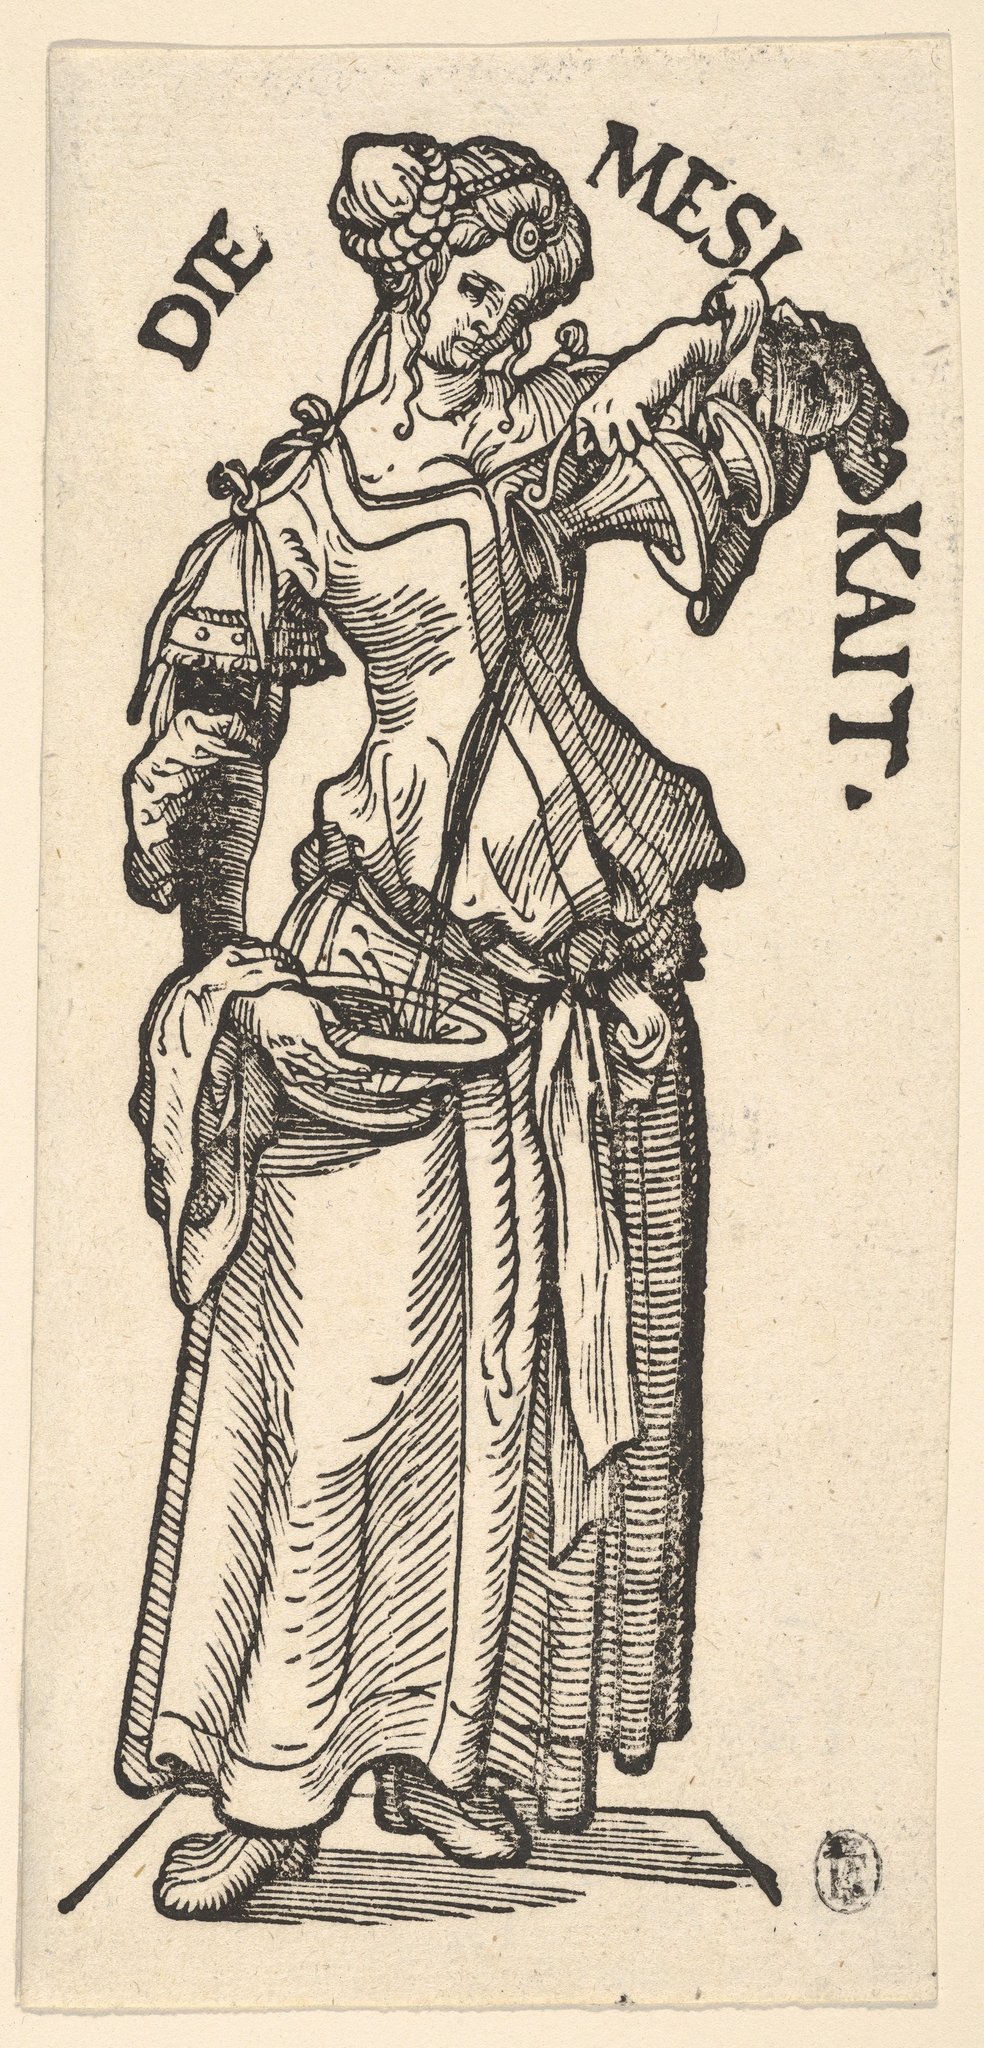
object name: print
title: Temperance (Die Mesikait), from "The Seven Virtues"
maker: hans burgkmair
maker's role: artist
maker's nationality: german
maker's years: 1473-1531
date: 1498-1531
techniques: woodcut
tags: women